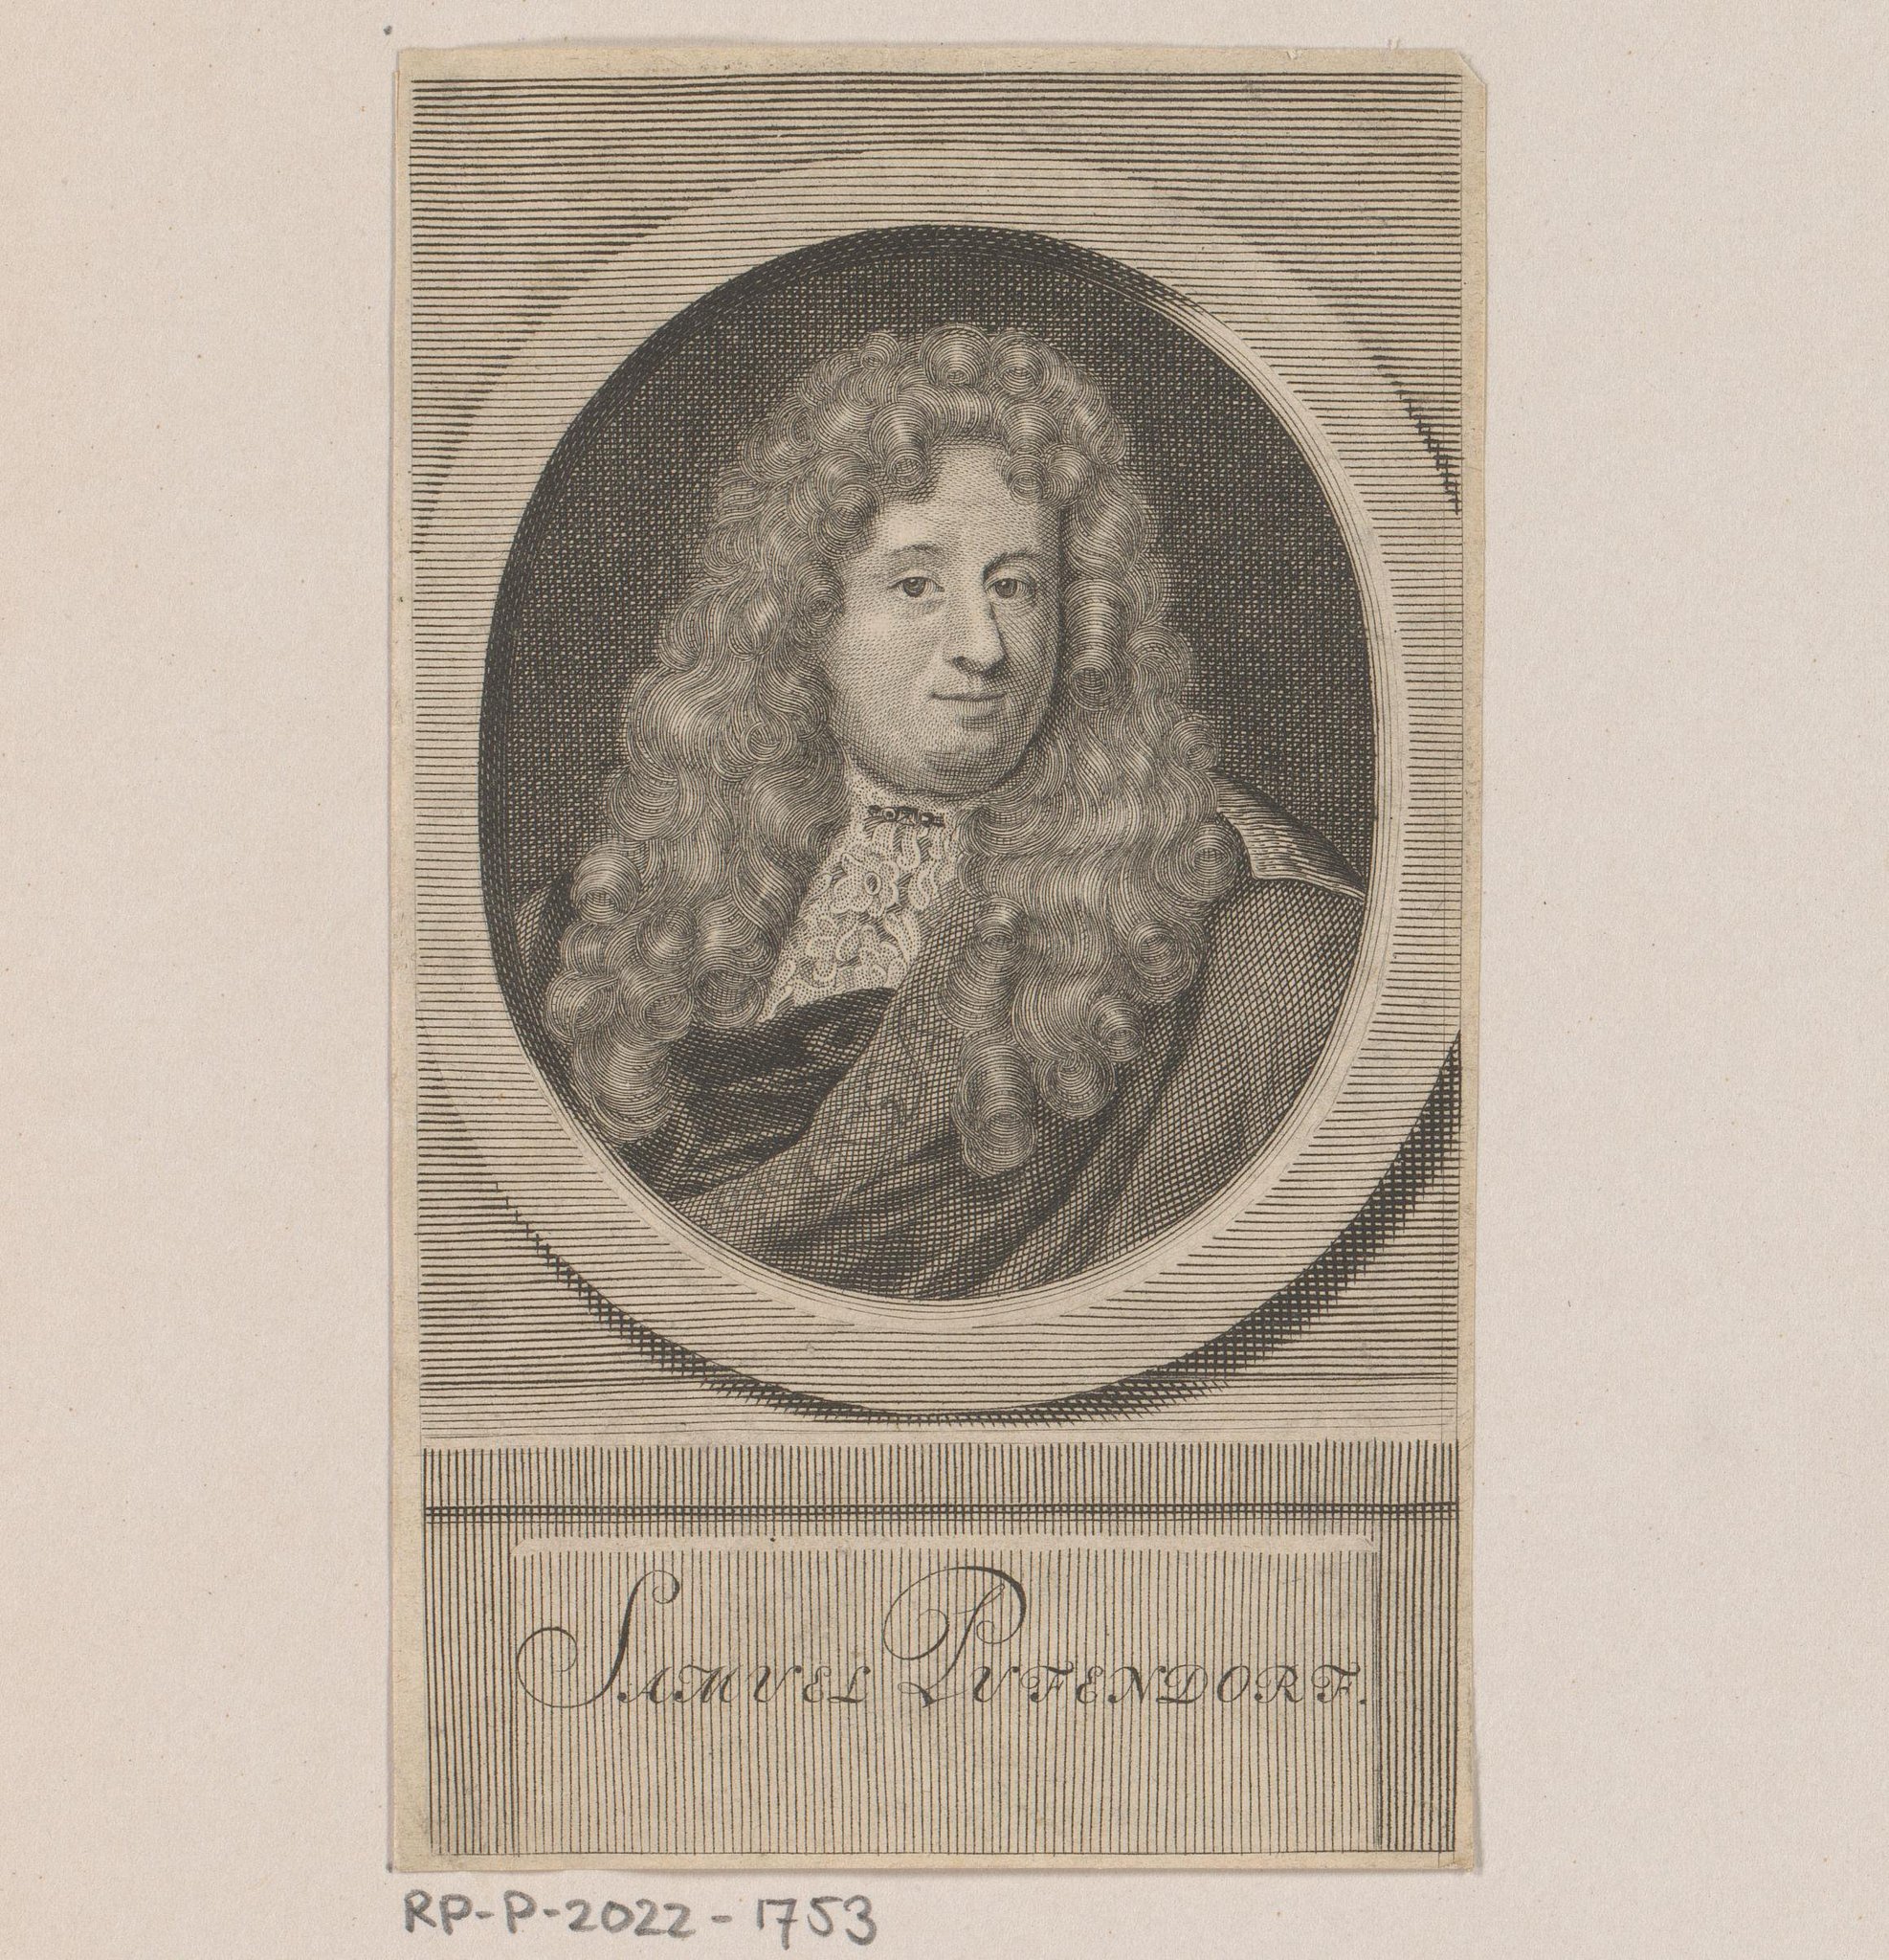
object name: print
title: Portret van Samuel von Pufendorf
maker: Anonymous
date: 1700-1799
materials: paper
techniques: engraving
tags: berlin, history and archaeology (+ portrait of scholar, scientist), scholar, philosopher, historical persons